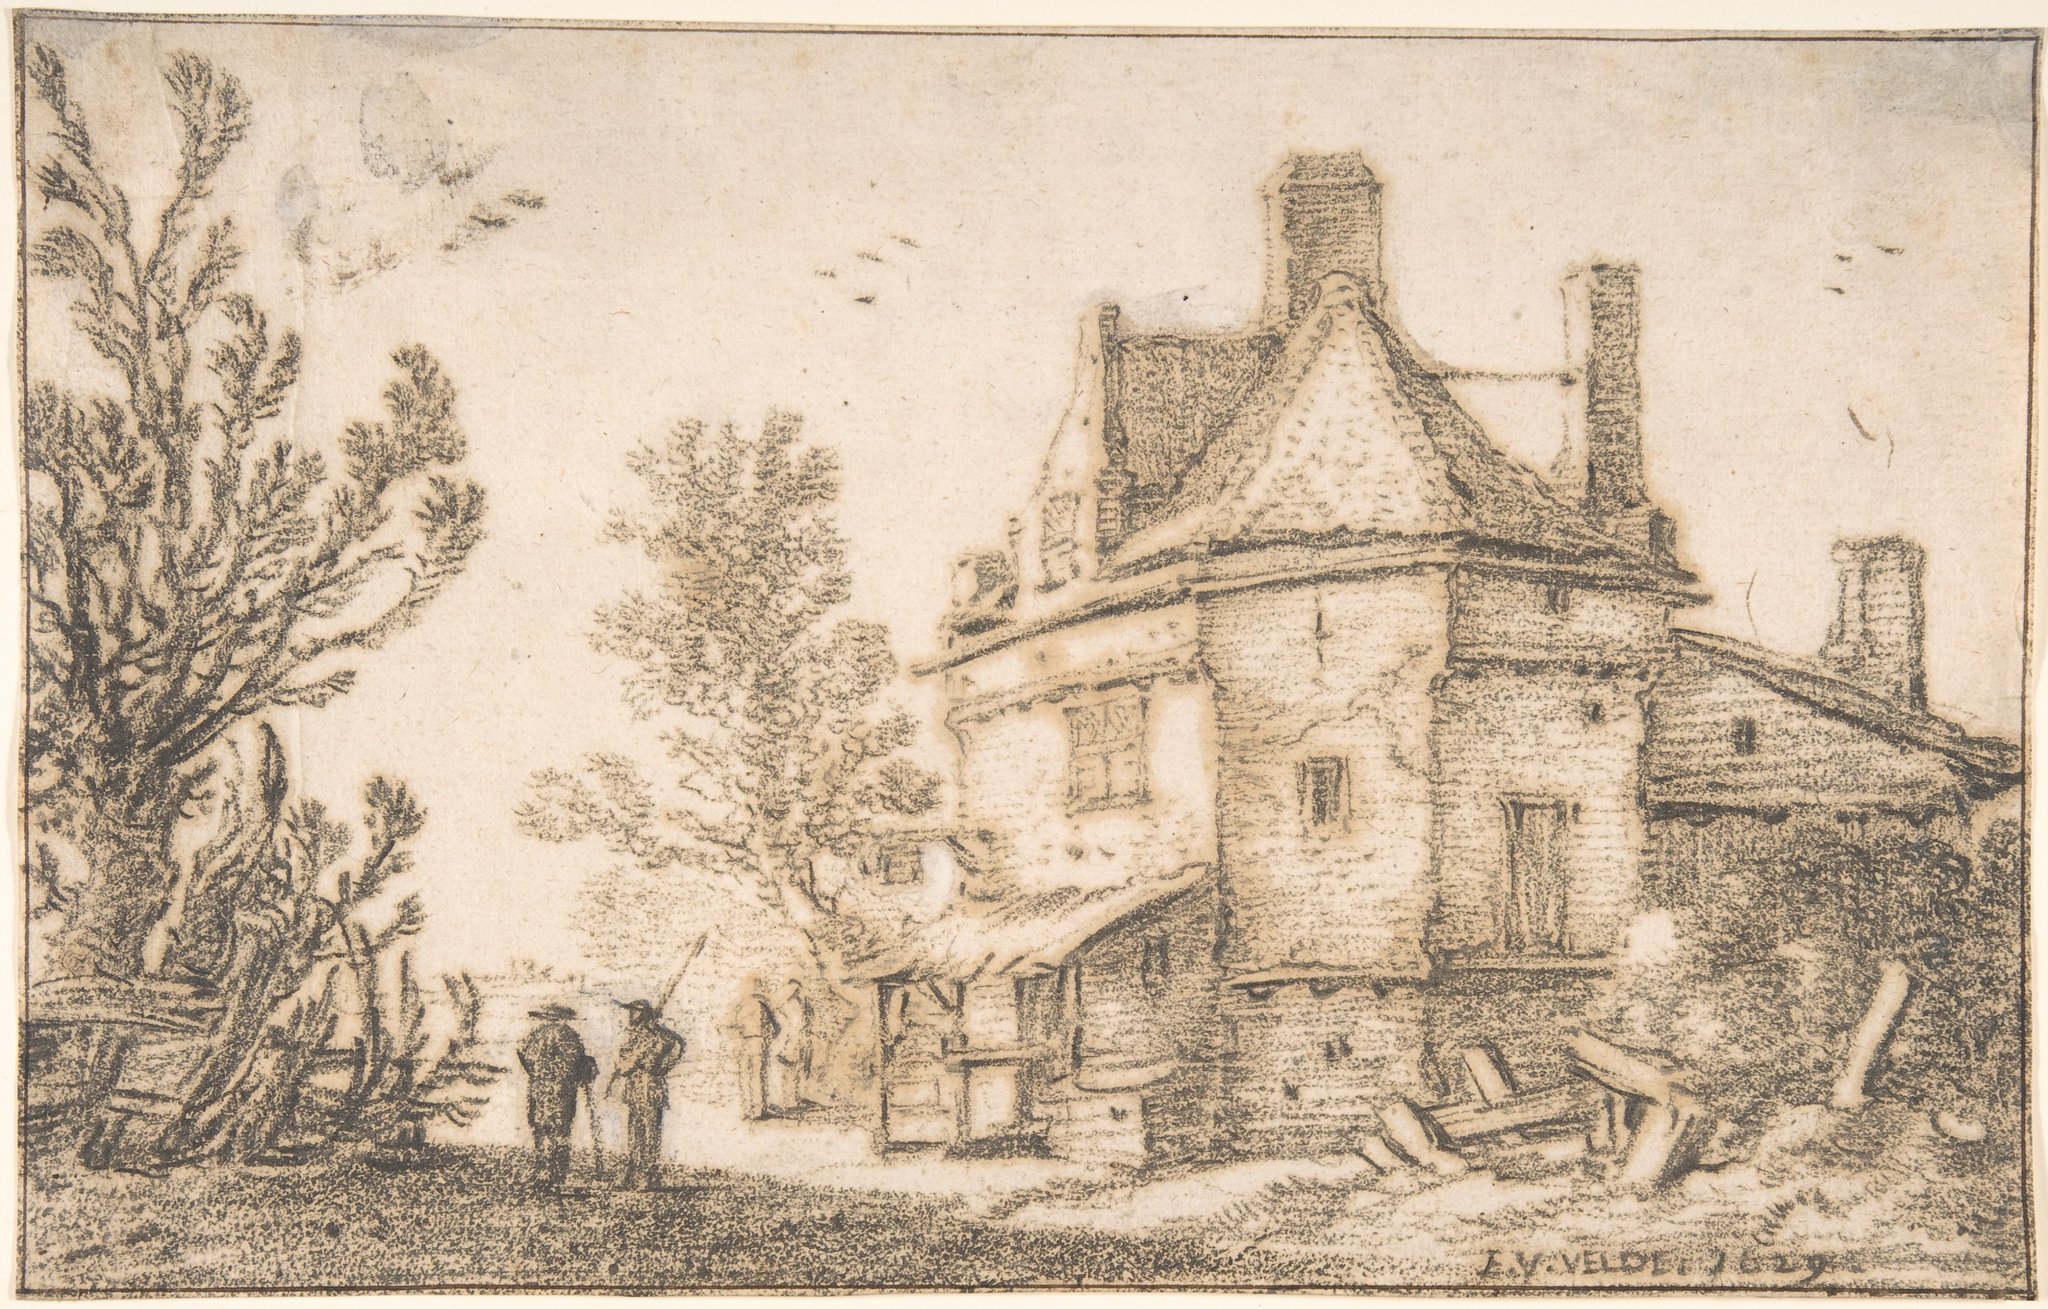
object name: drawing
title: Landscape with an Inn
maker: esaias van de velde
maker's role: artist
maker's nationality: dutch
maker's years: 1587-1630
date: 1629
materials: charcoal, oil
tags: human figures,inns,landscapes